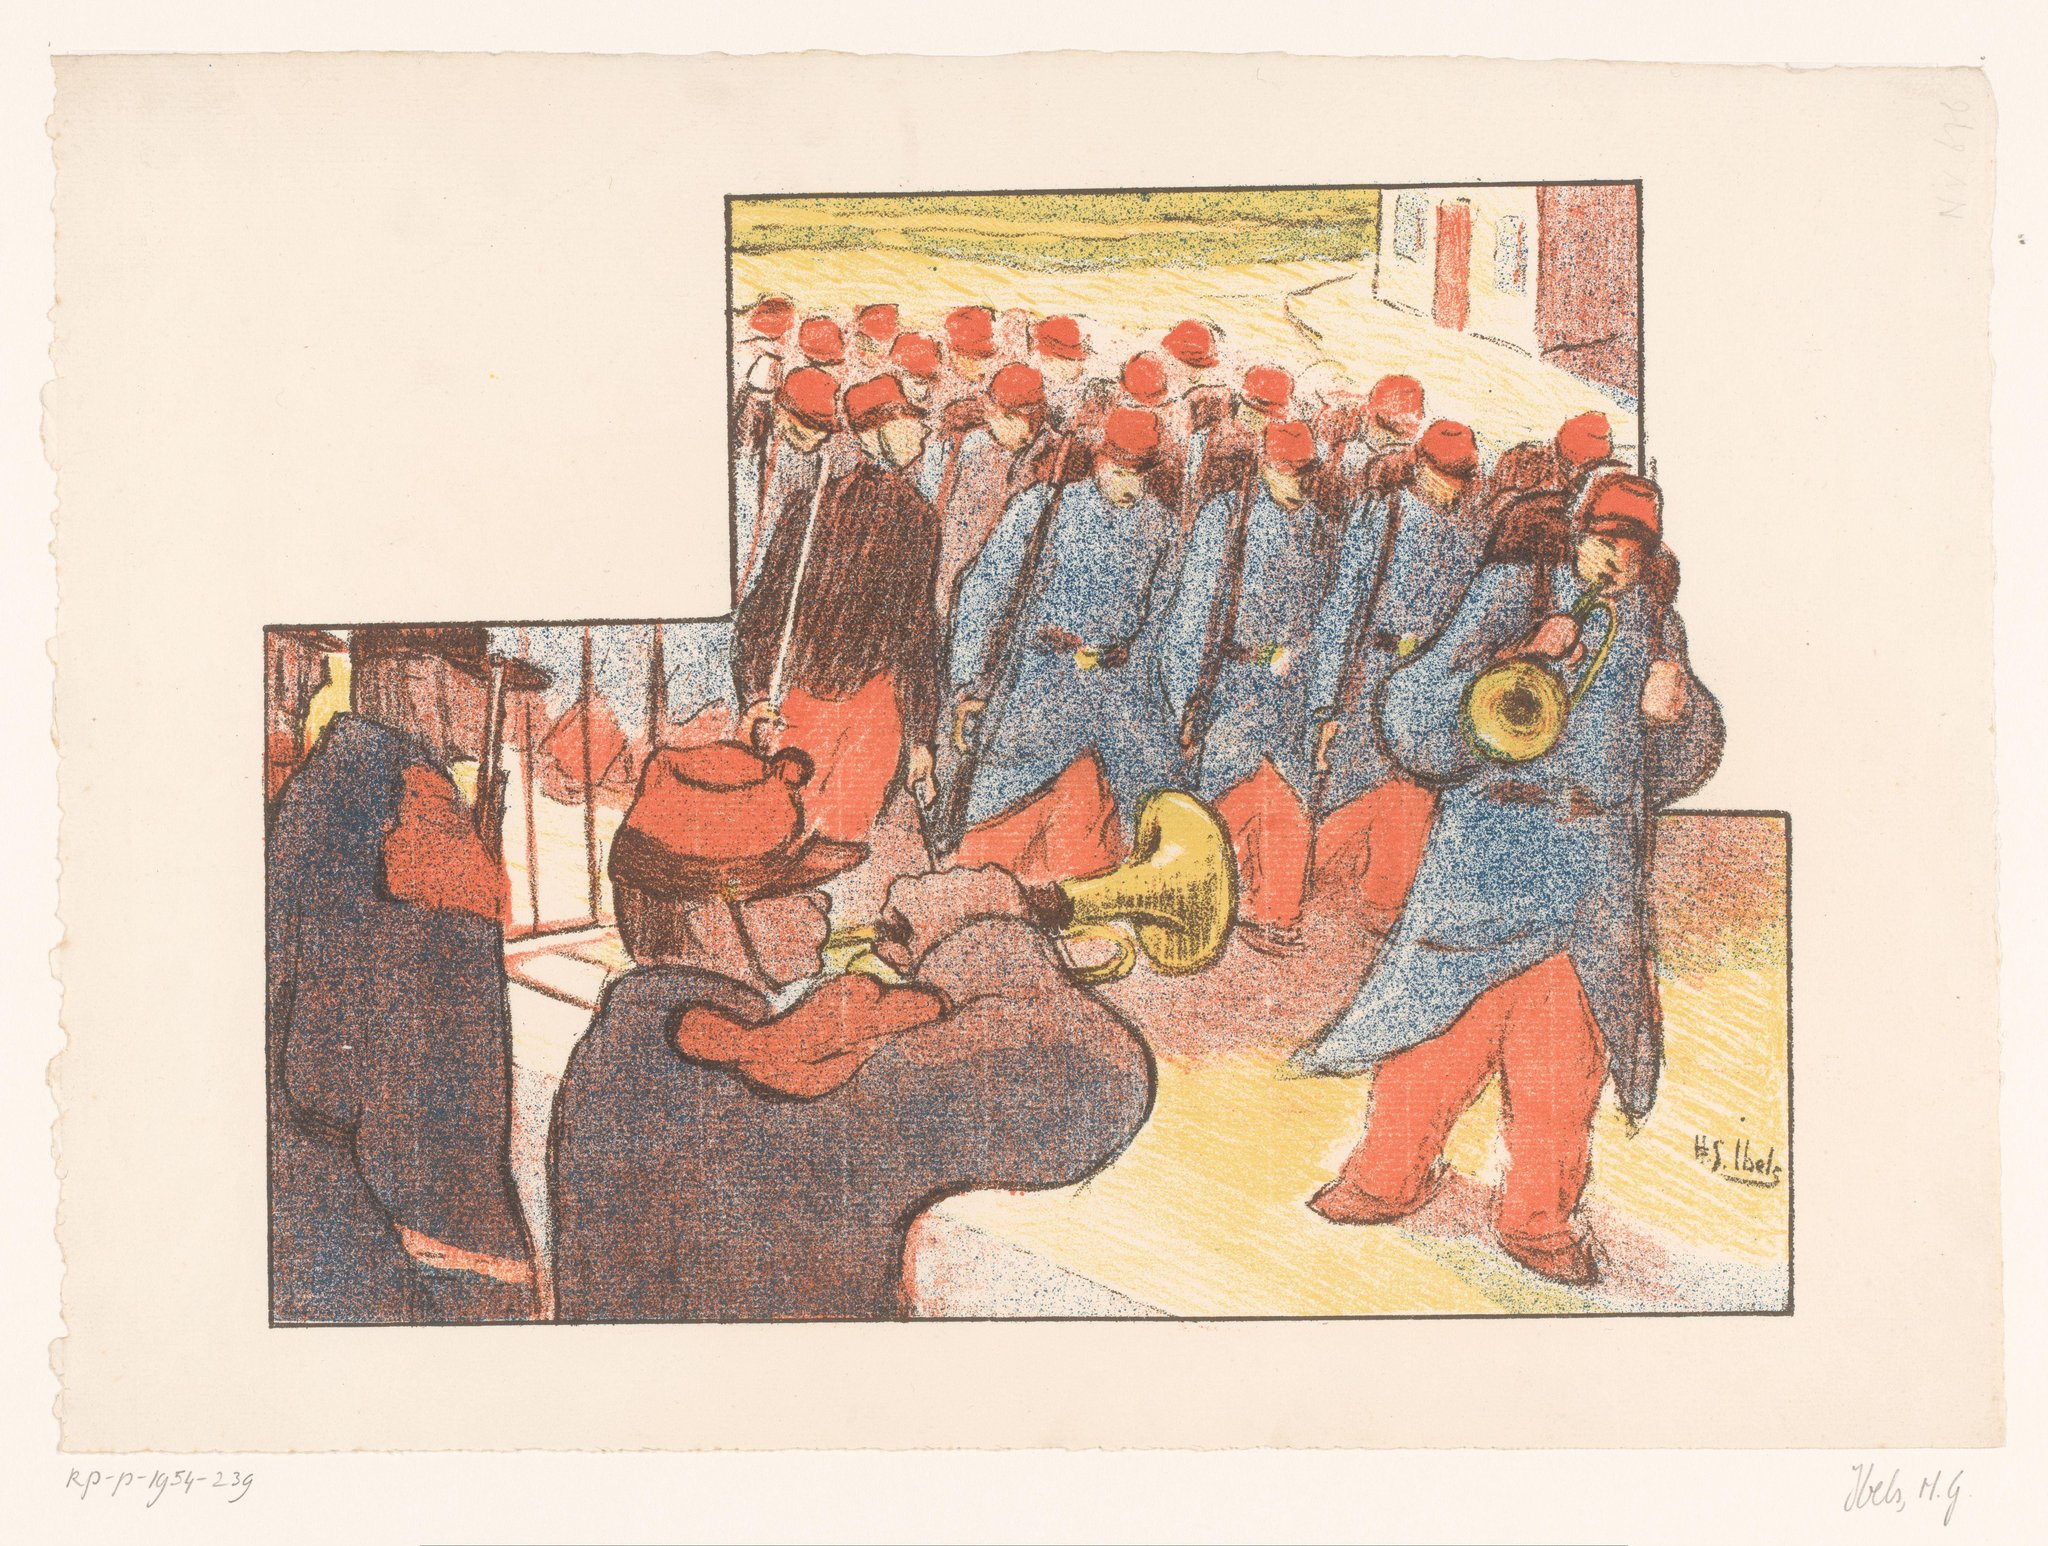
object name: print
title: Les Programmes du Théâtre Libre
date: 1892-1893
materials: paper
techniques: lithograph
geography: paris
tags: horn, trumpet, cornet, trombone, tuba - cc - out of doors, military parade, pageant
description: Ontwerp voor het programma van de theatervoorstellingen A Bas le Progrès!, Mademoiselle Julie en Le Ménage Brésile (3e spectacle).